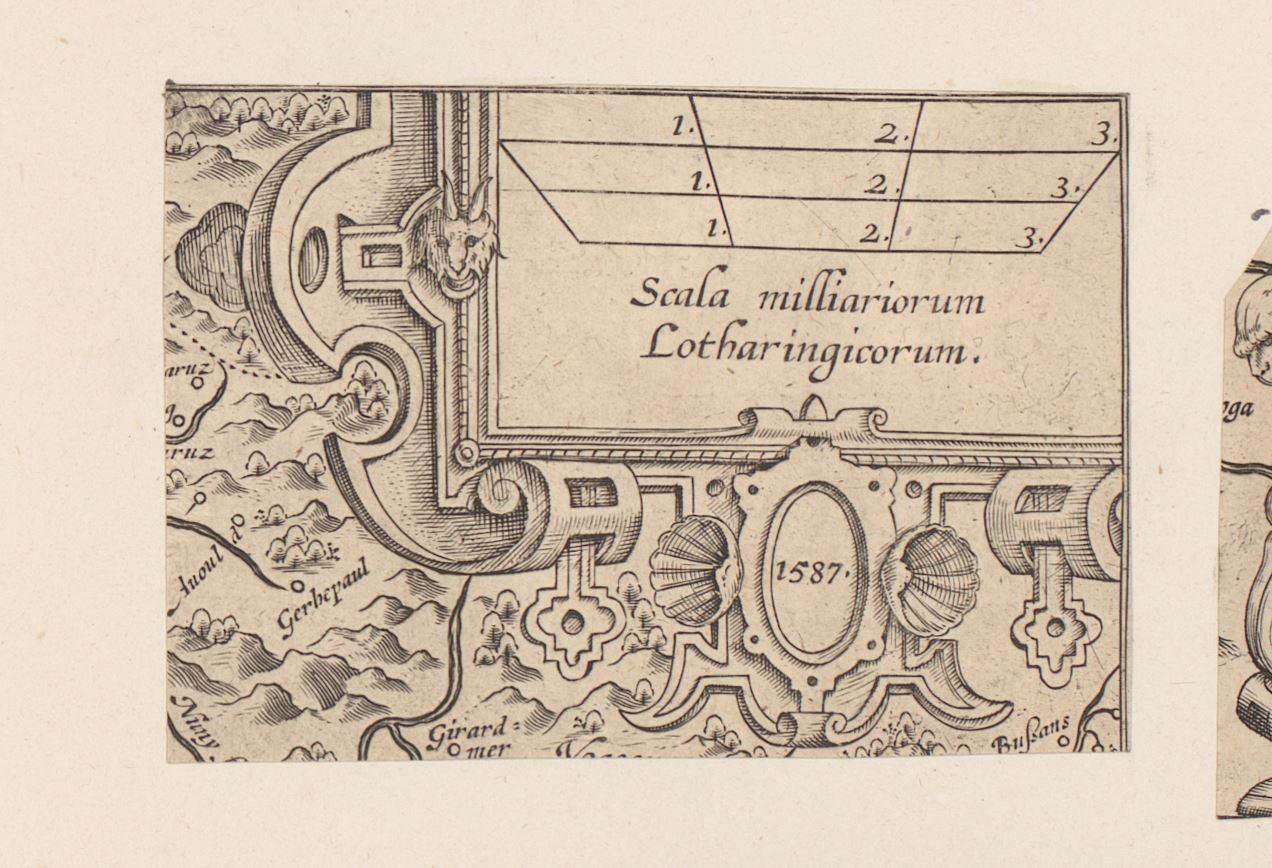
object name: ornament print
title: Cartouche van een kaart van Lotharingen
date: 1587-1590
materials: paper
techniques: engraving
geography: antwerp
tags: scallop, shell ~ ornament, ornament ~ cartouche, mask, mascaron ~ ornament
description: Hoekcartouche met schaalstok (Scala milliariorum Lotharingicorum) en omlijst met rolwerk, masker en schelpornamenten. De cartouche is een fragment van een kaart van Lotharingen. De prent maakt deel uit van een album.